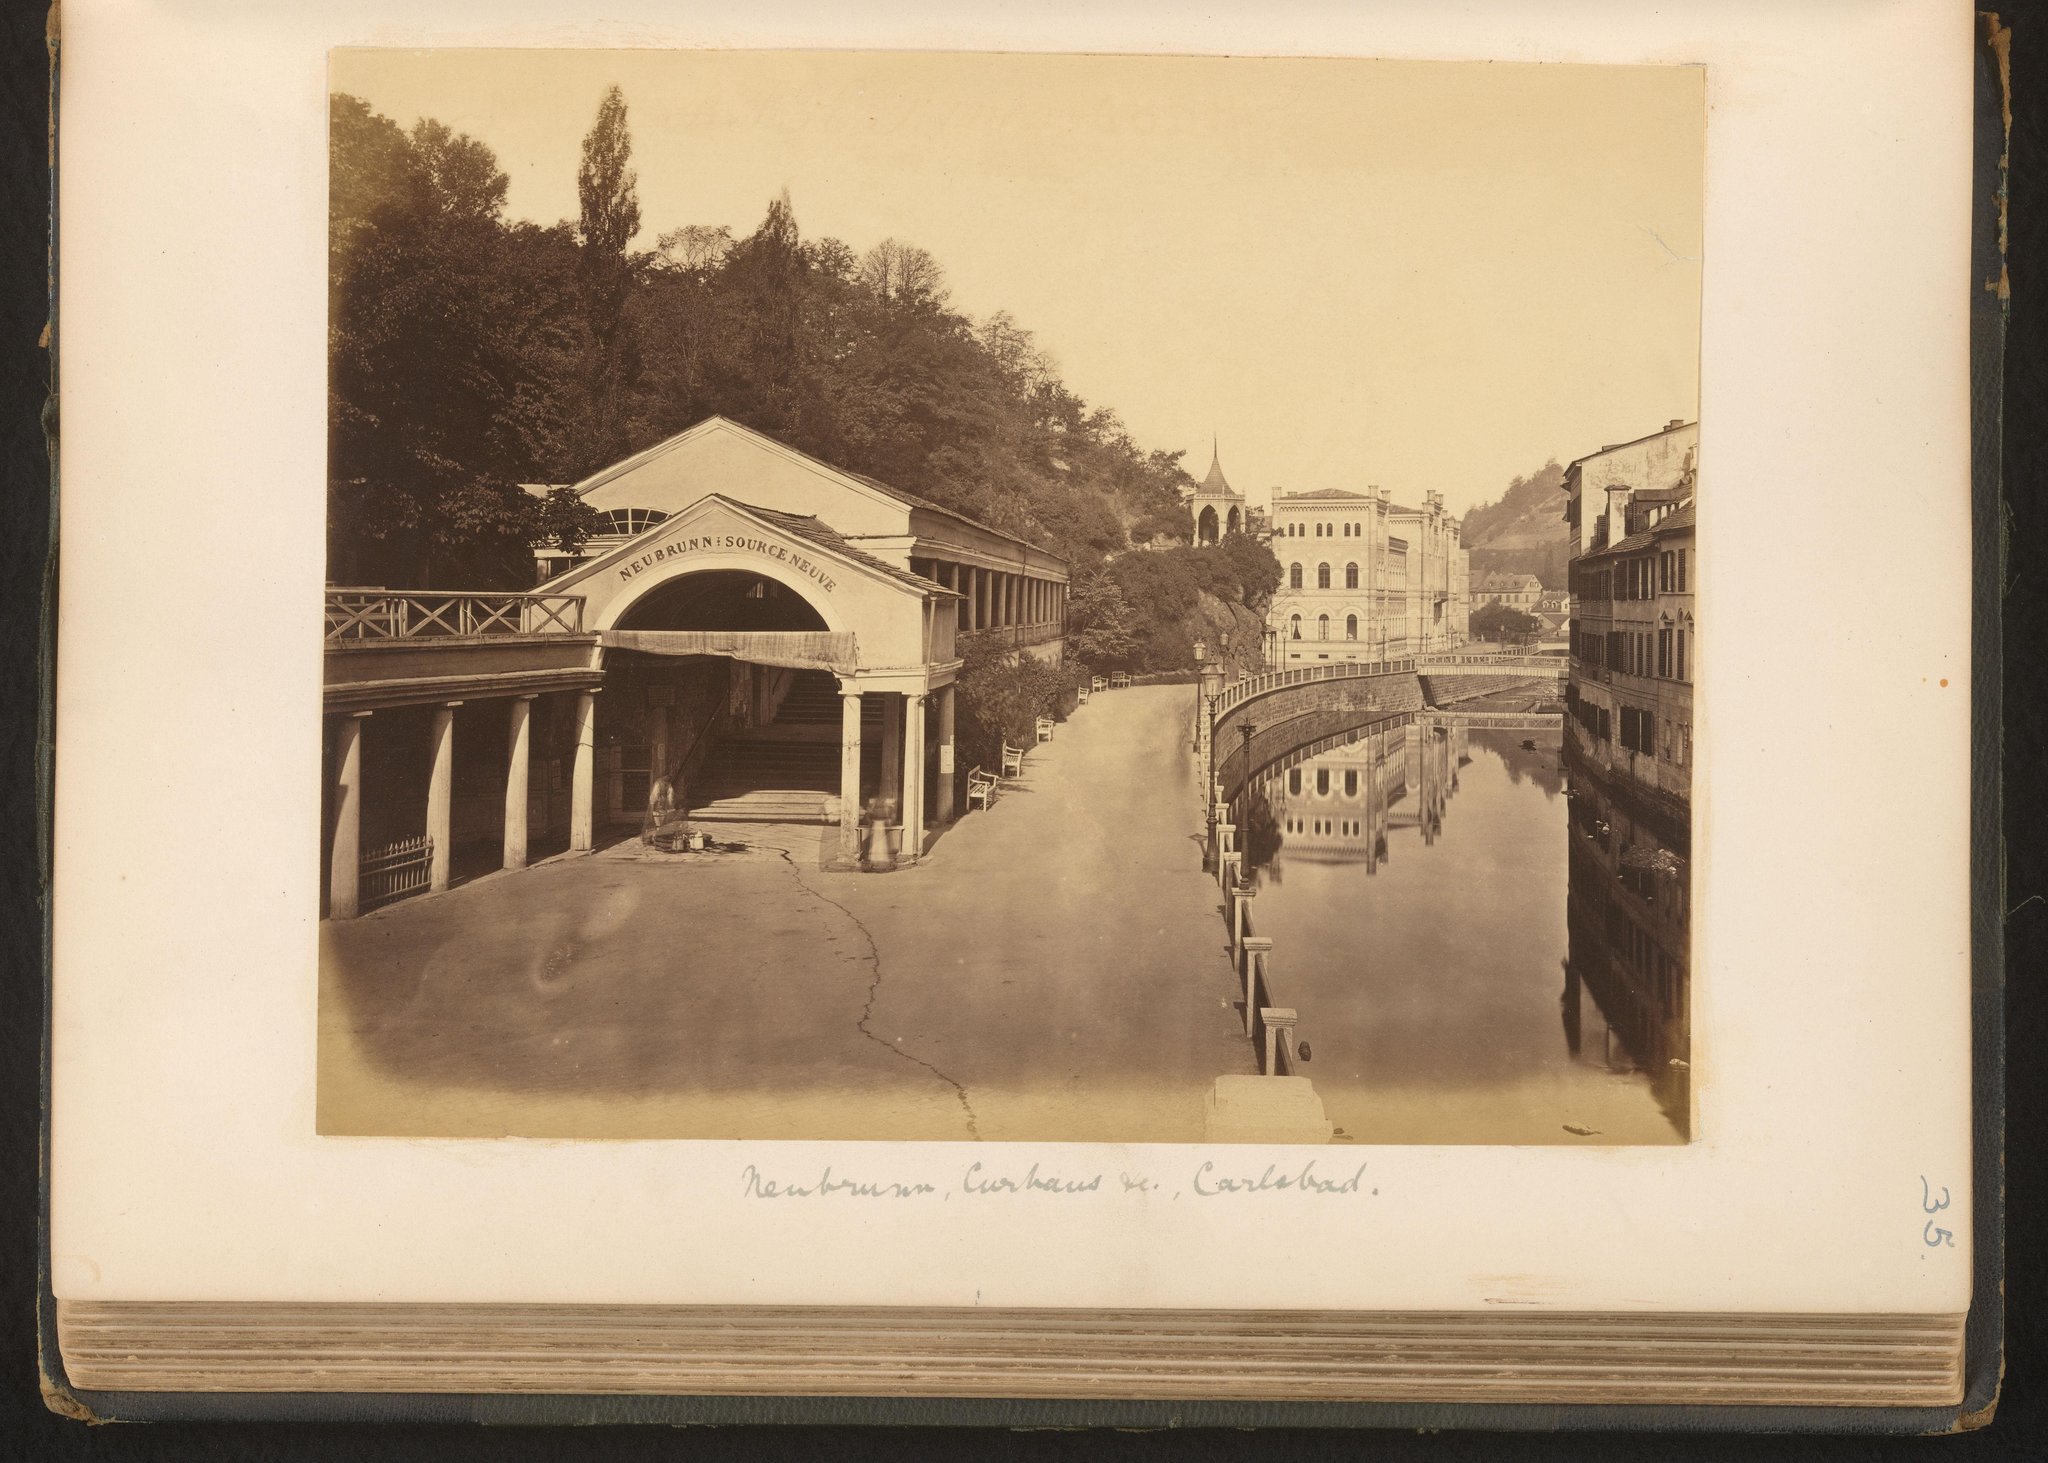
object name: photograph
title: Gezicht op een water te Karlovy Vary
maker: Anonymous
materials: paper, photographic support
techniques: albumen print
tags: canals, waters (in city)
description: Deze pagina maakt deel uit van een album.